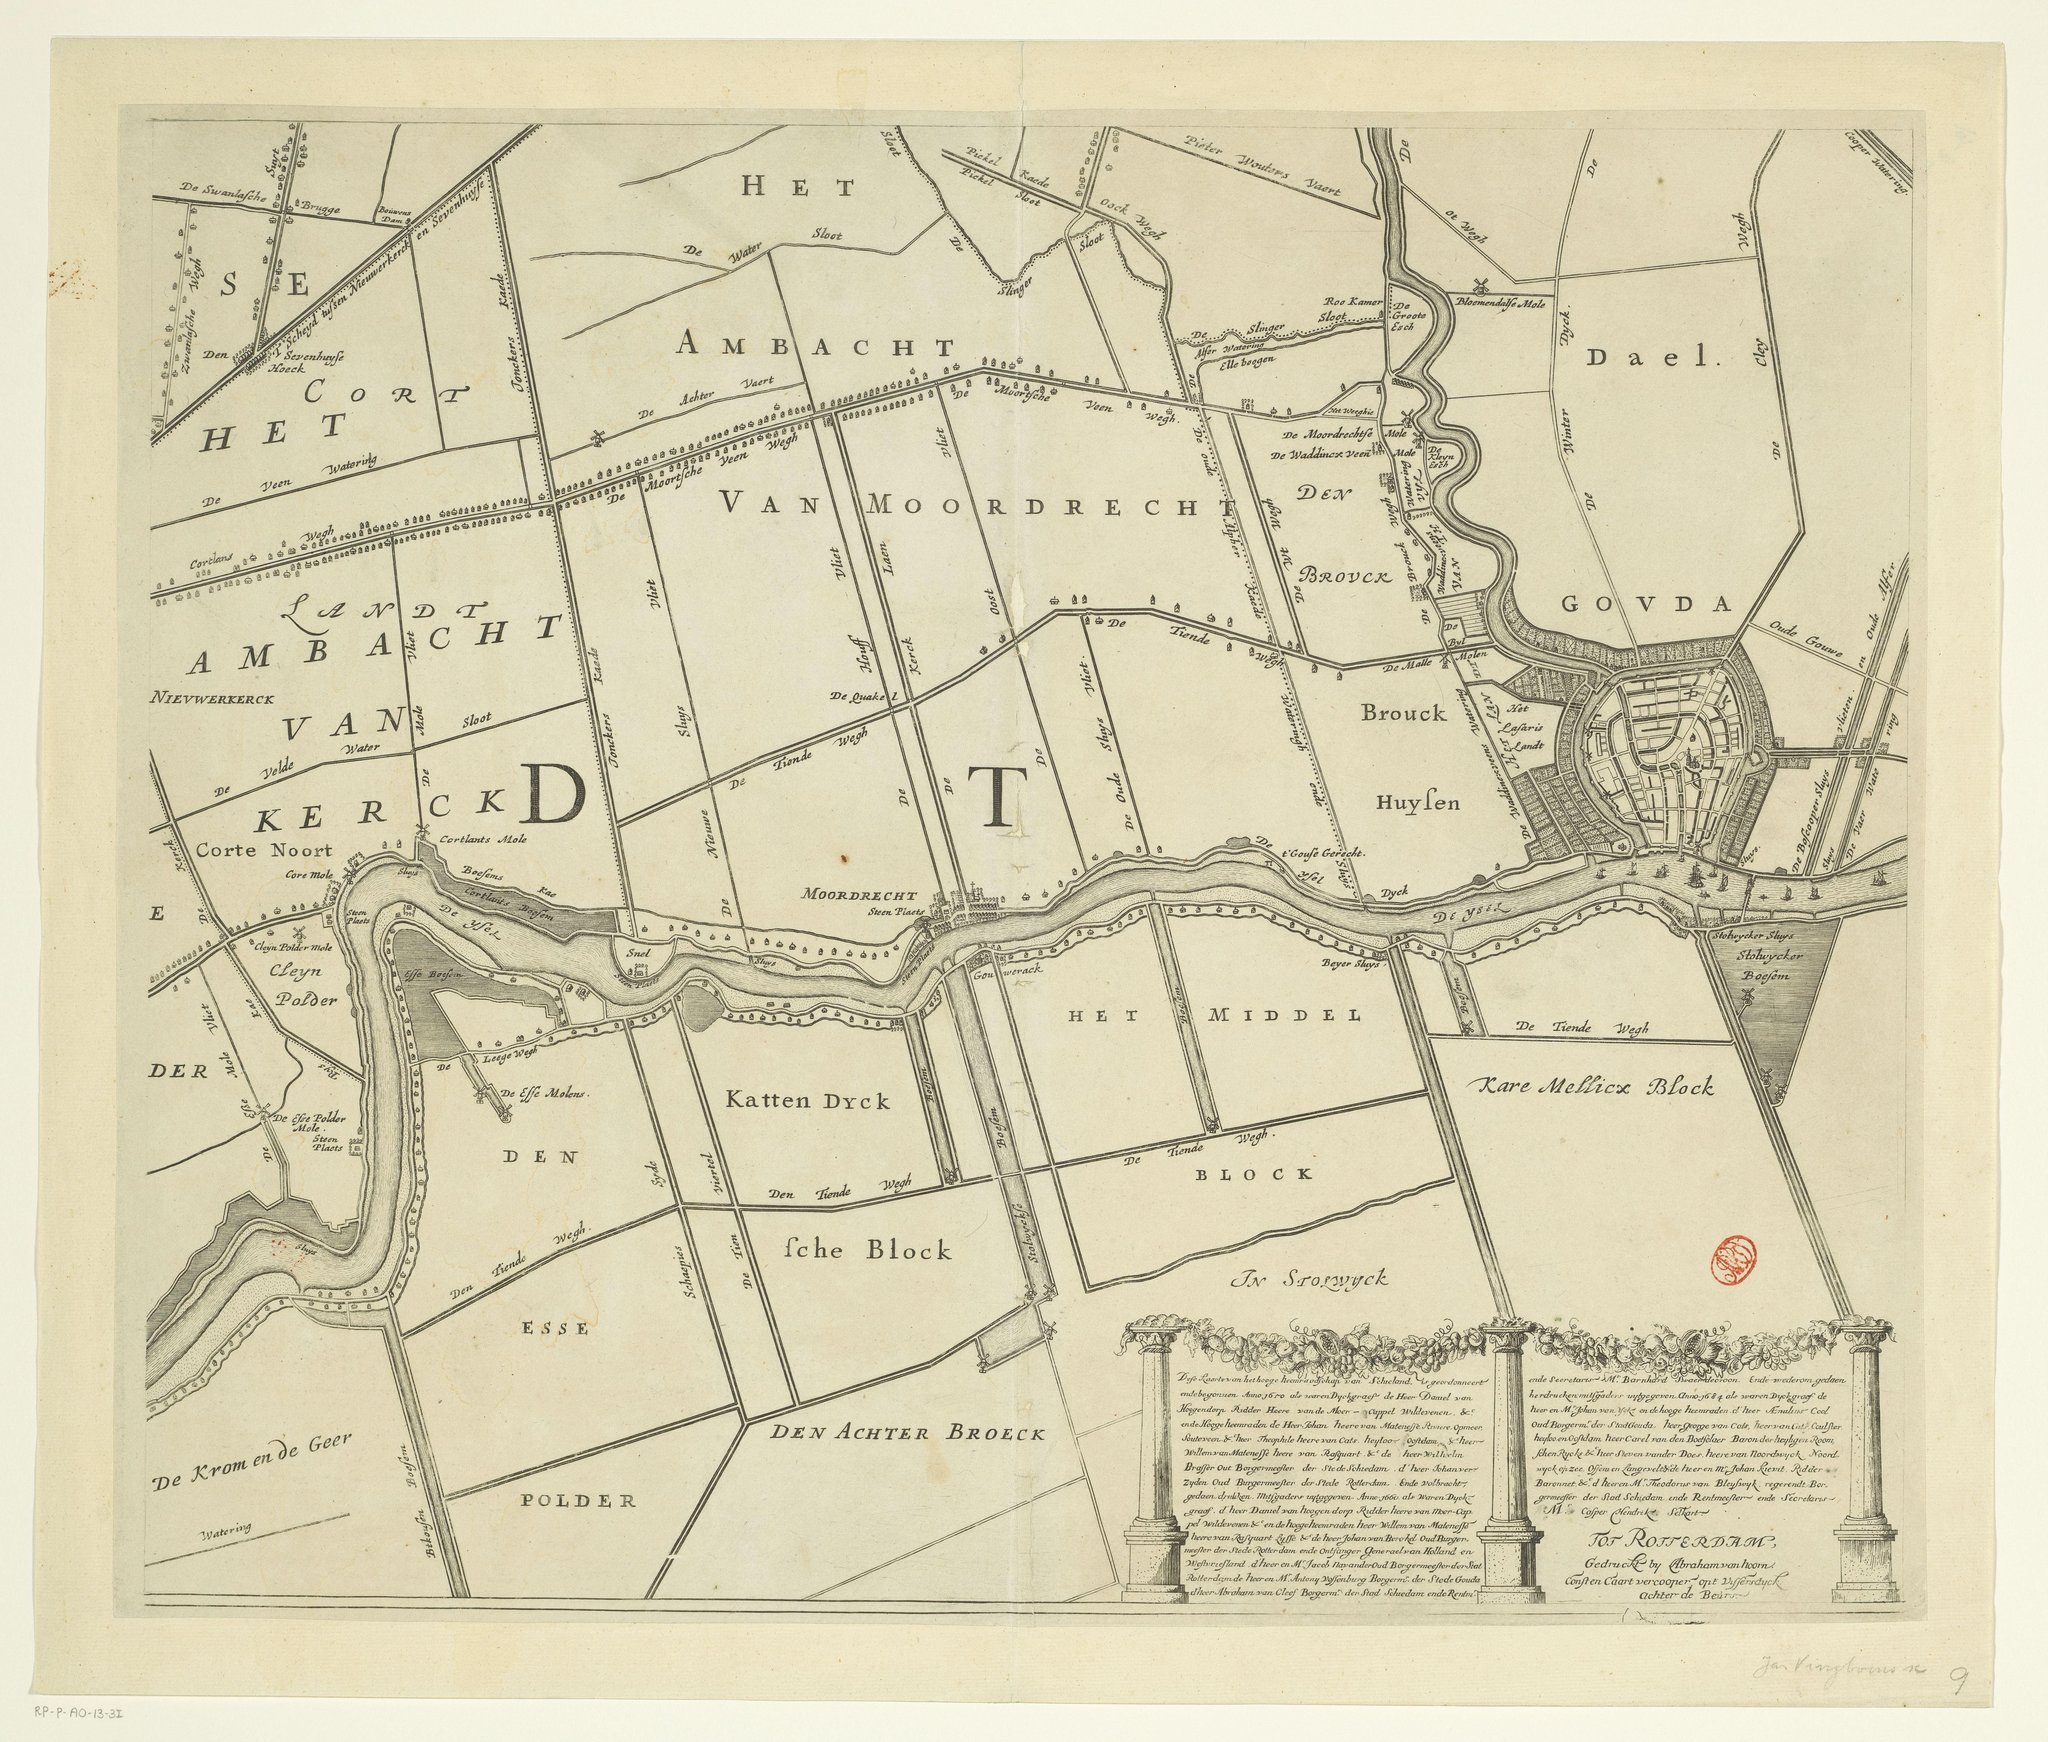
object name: print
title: Kaart van het Hoogheemraadschap van Schieland (negende deel)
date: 1684-1718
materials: paper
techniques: engraving, etching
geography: amsterdam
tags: maps of separate countries or regions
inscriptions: collector's mark: Lugt 195, collector's mark: Lugt 2228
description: Negende deel van een kaart van het Hoogheemraadschap van Schieland bestaande uit negen delen.